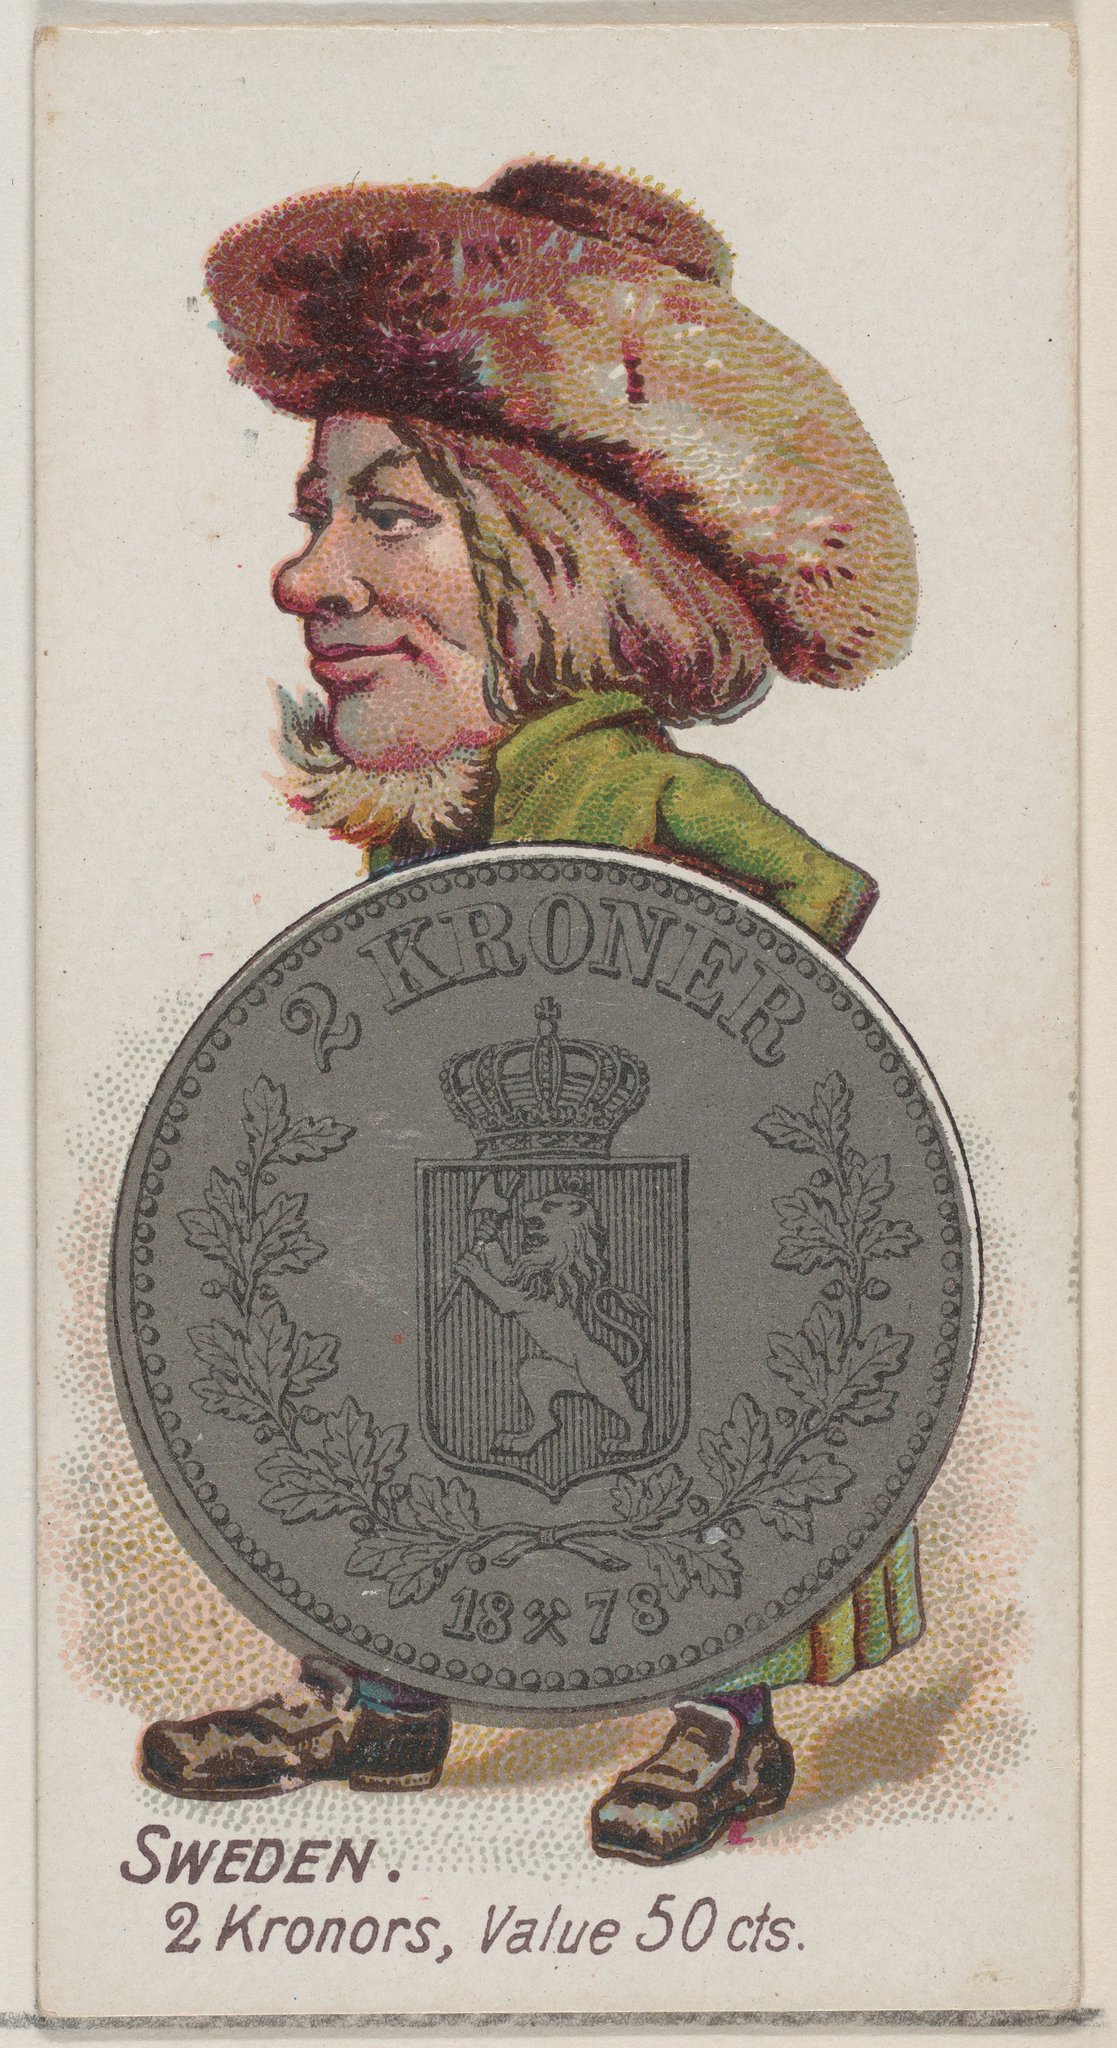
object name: print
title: Sweden, 2 Kronors, from the series Coins of All Nations (N72, variation 1) for Duke brand cigarettes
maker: w. duke, sons & co.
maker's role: publisher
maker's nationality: american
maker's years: 1870-1920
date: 1889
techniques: color lithograph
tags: coins